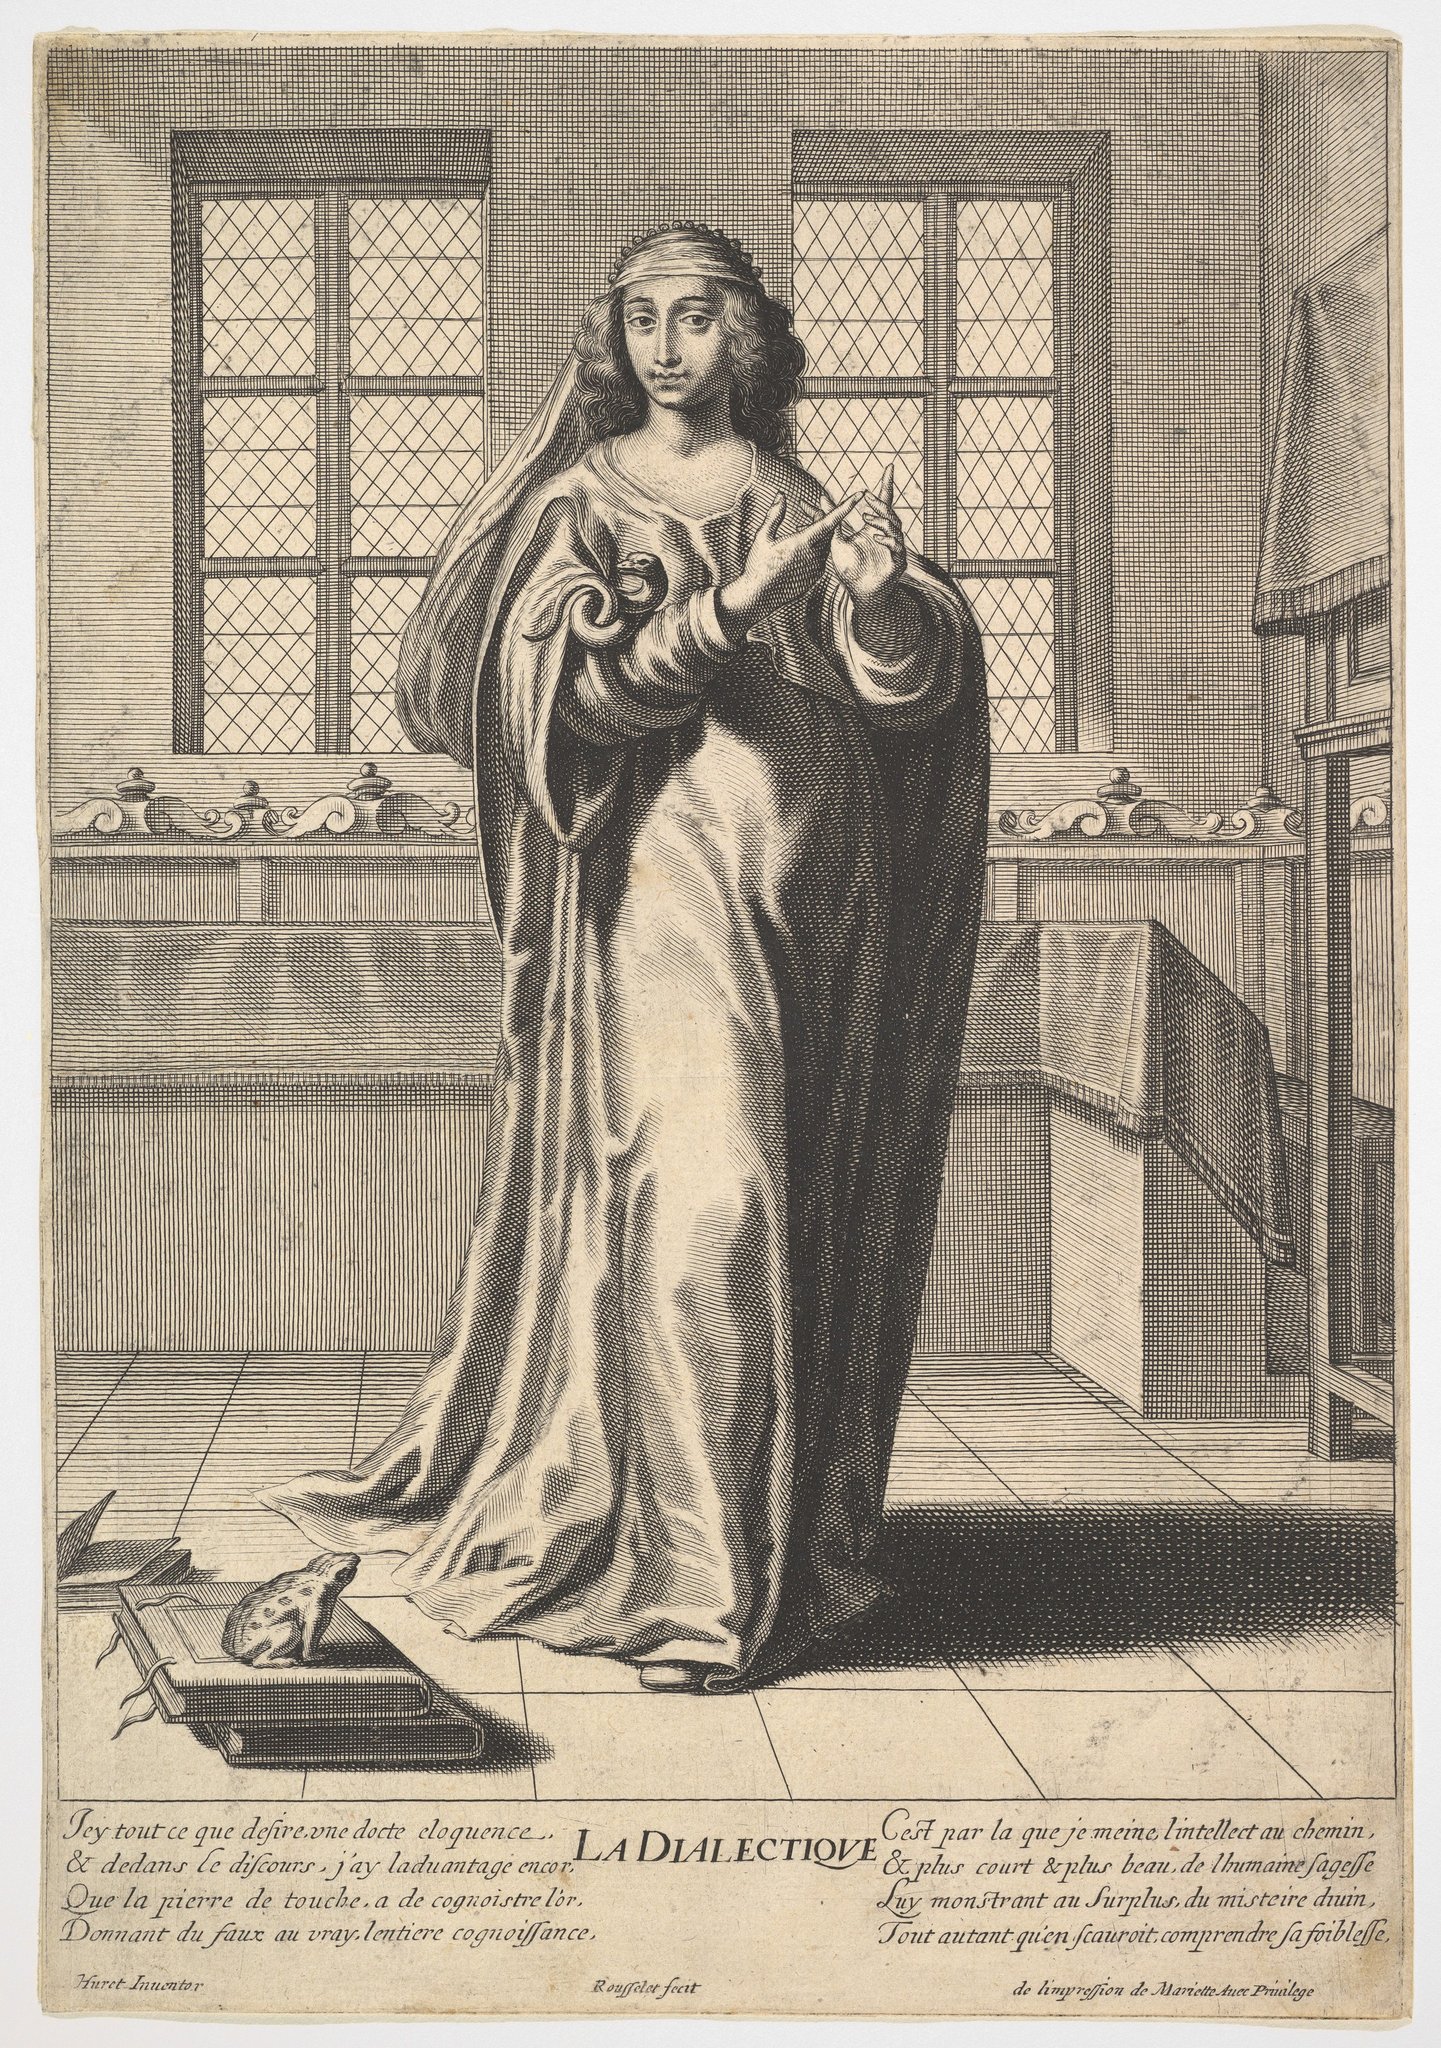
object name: print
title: Dialectic: a young woman standing in a decorated interior and touching her right index finger to her left middle finger in a counting gesture, at her feet is a toad seated on a stack of books, from "The liberal arts" (Les arts liberaux)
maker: gilles rousselet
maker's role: artist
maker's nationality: french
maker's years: 1614-1686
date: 1633-1635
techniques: engraving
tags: books,women,frogs